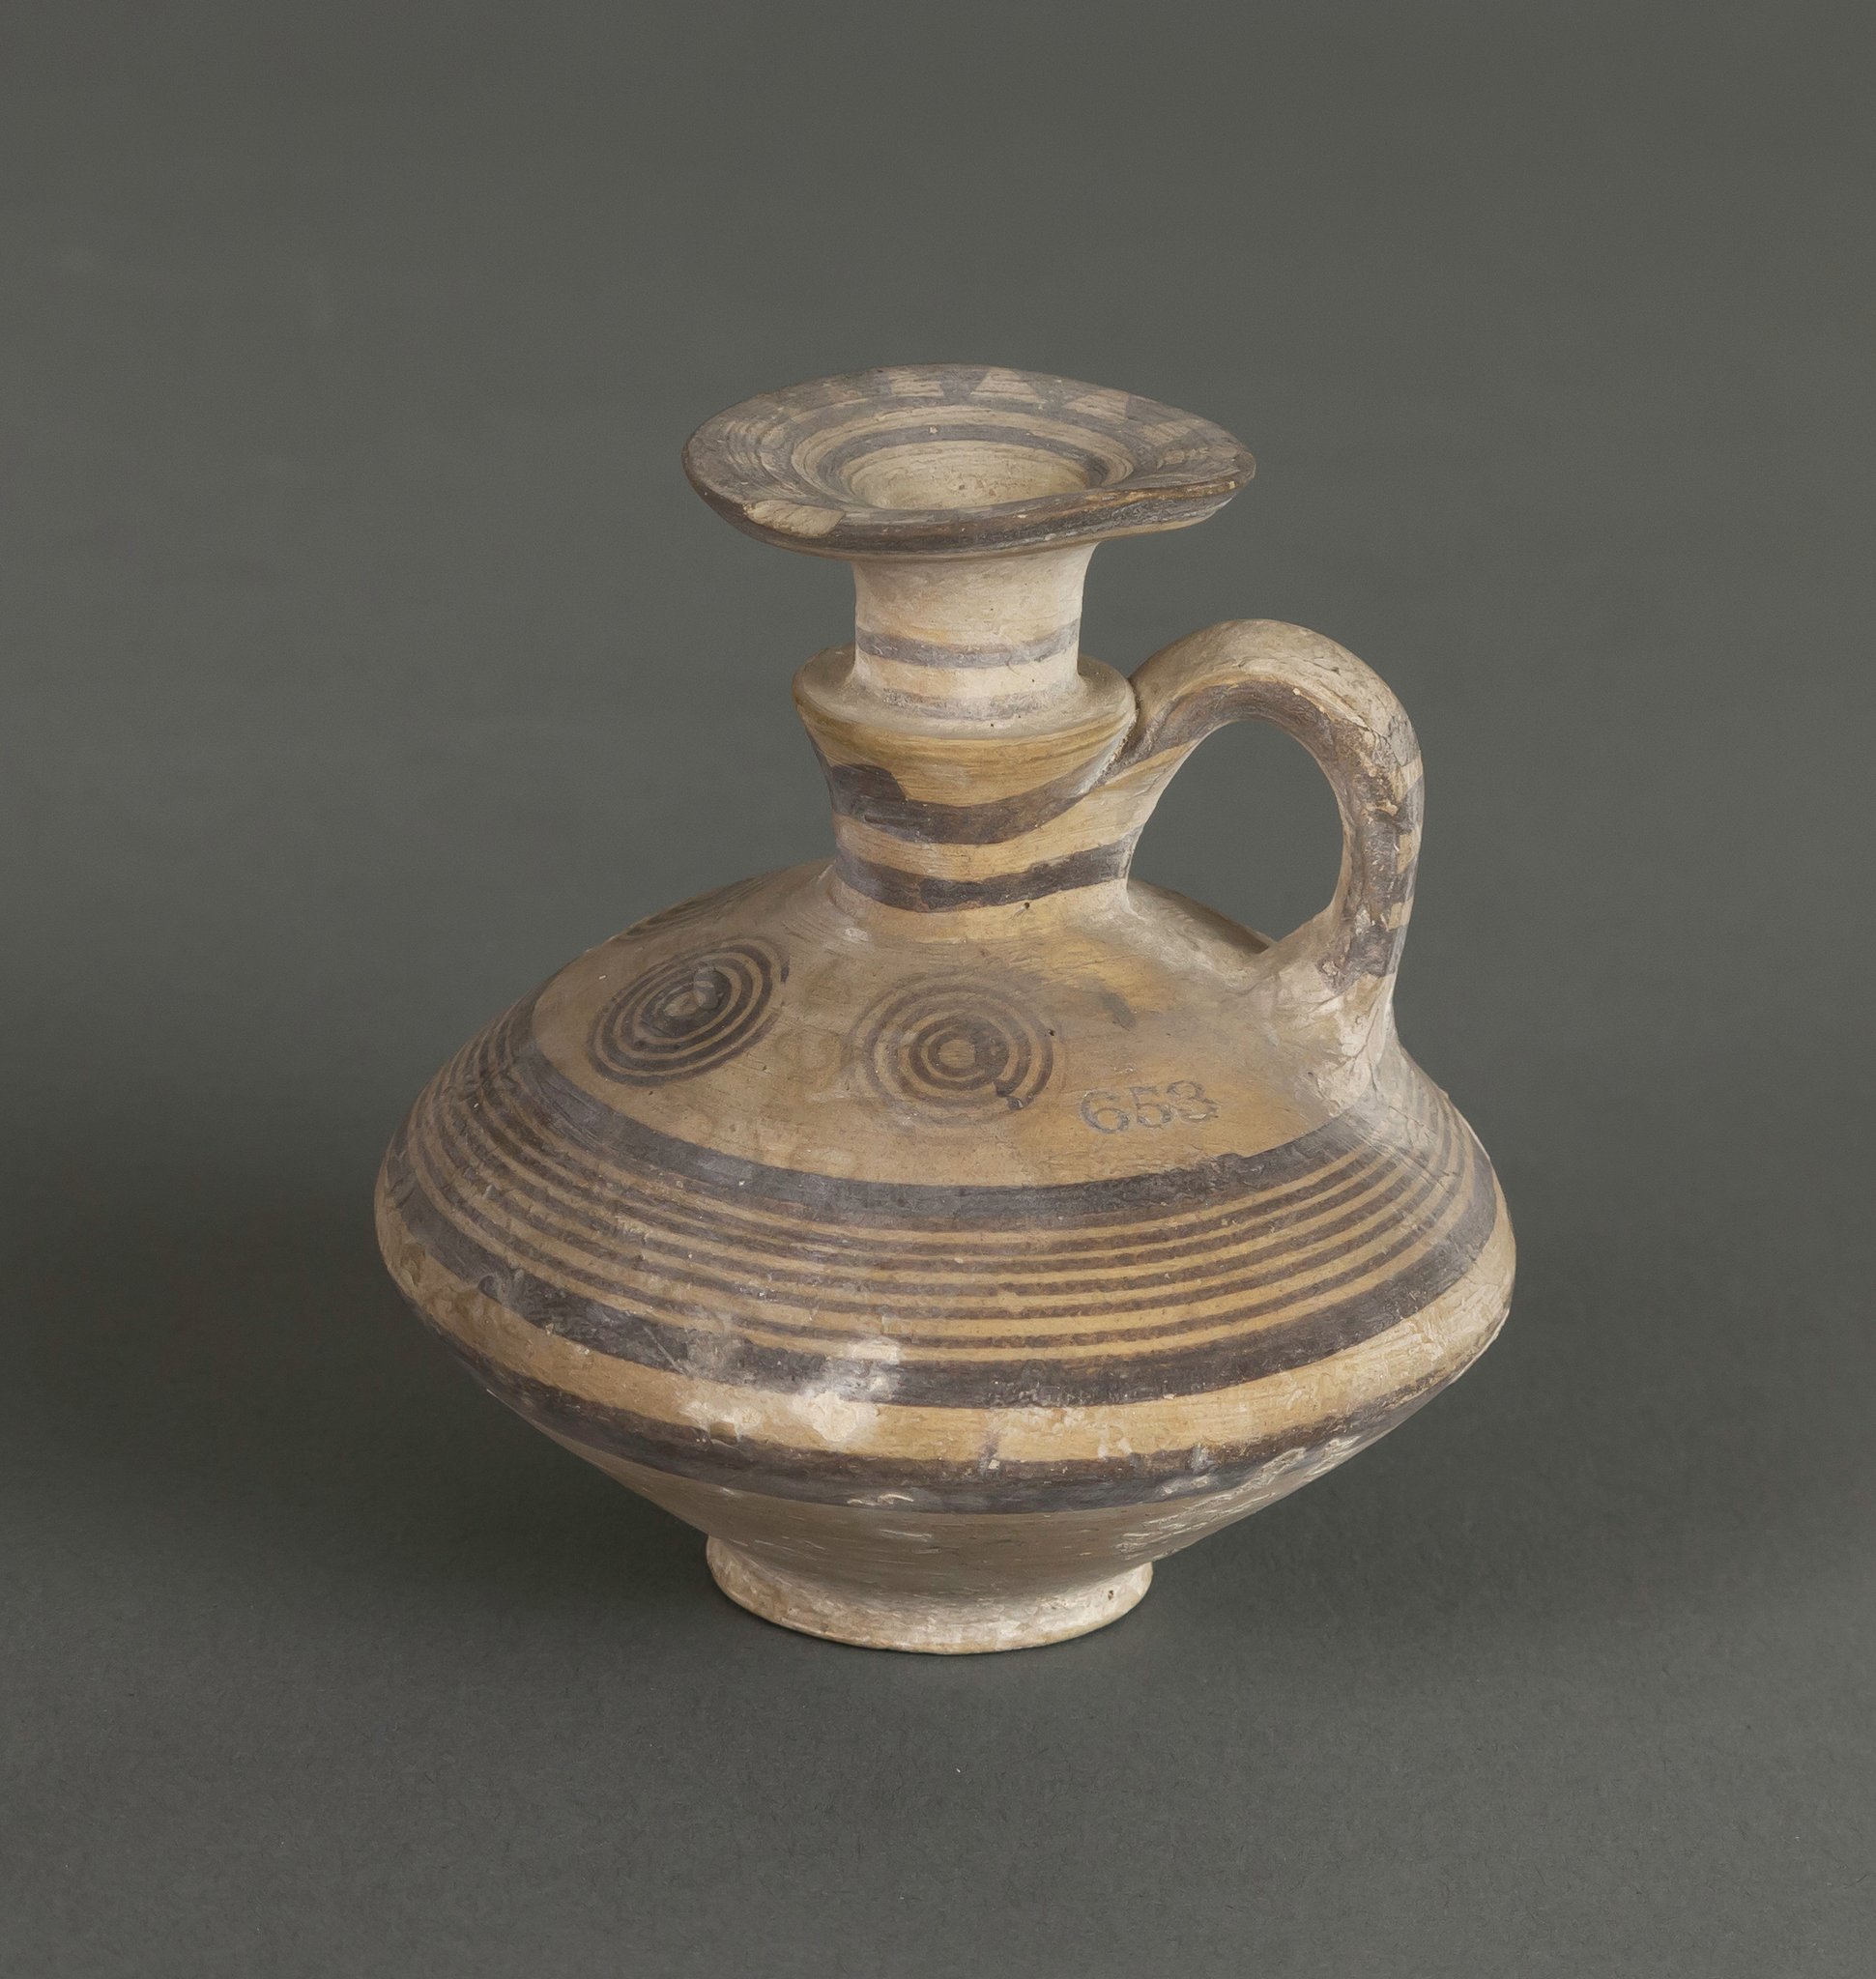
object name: jug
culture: cypriot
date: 1050-900 BCE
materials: terracotta